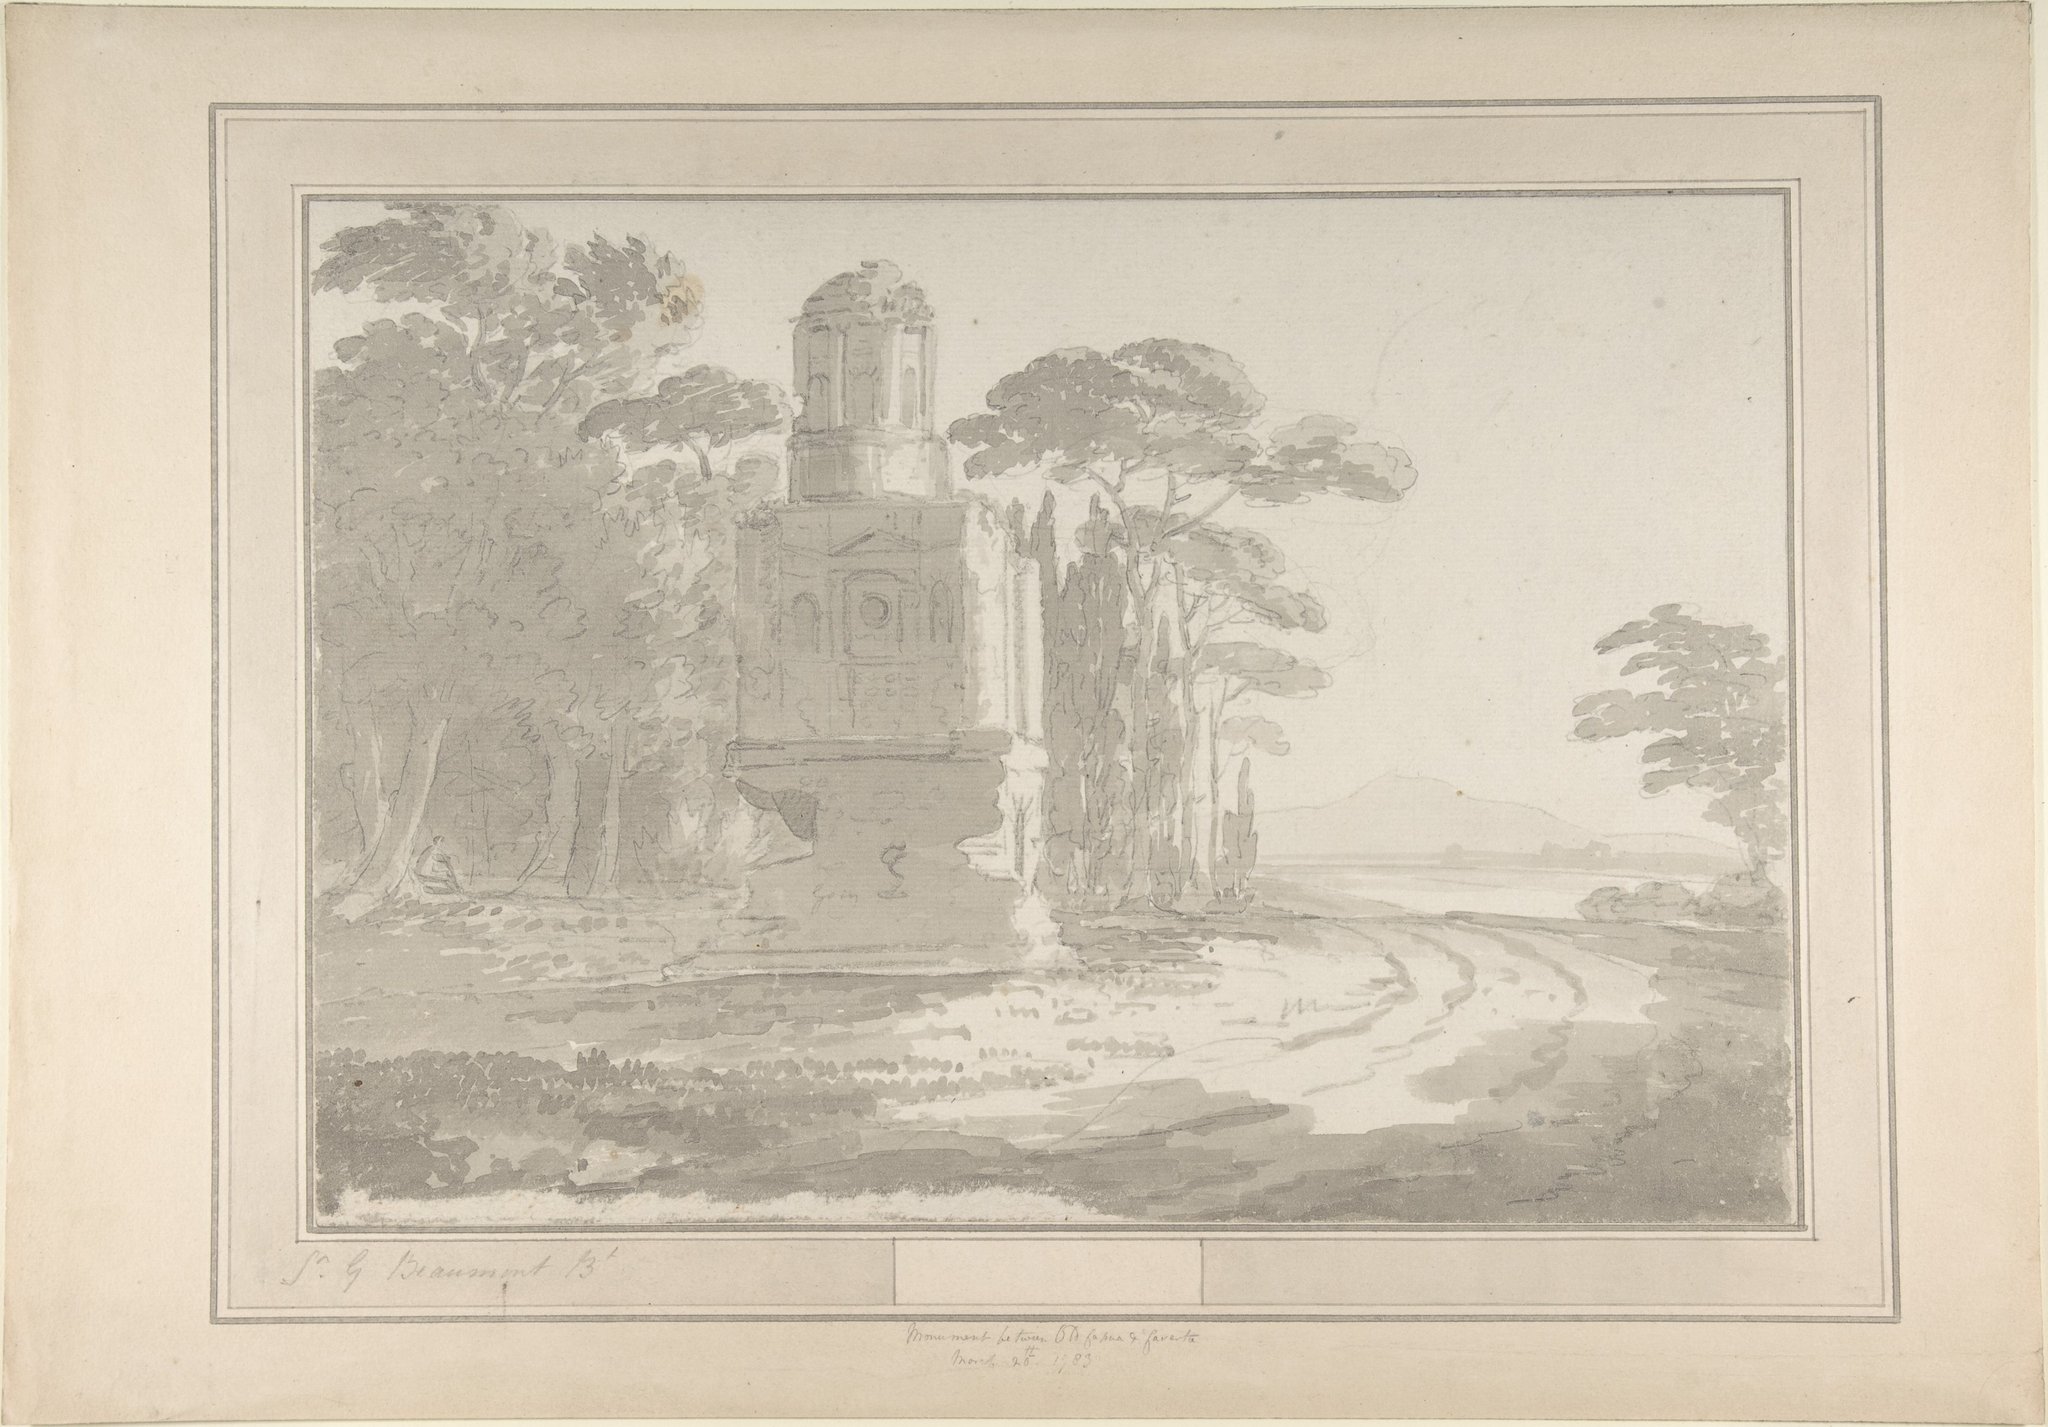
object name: drawing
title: Italian Landscape with a Tomb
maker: sir george howland beaumont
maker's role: artist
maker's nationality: british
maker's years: 1753-1827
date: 1783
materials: chalk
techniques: brush, wash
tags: tombs,roads,landscapes,trees